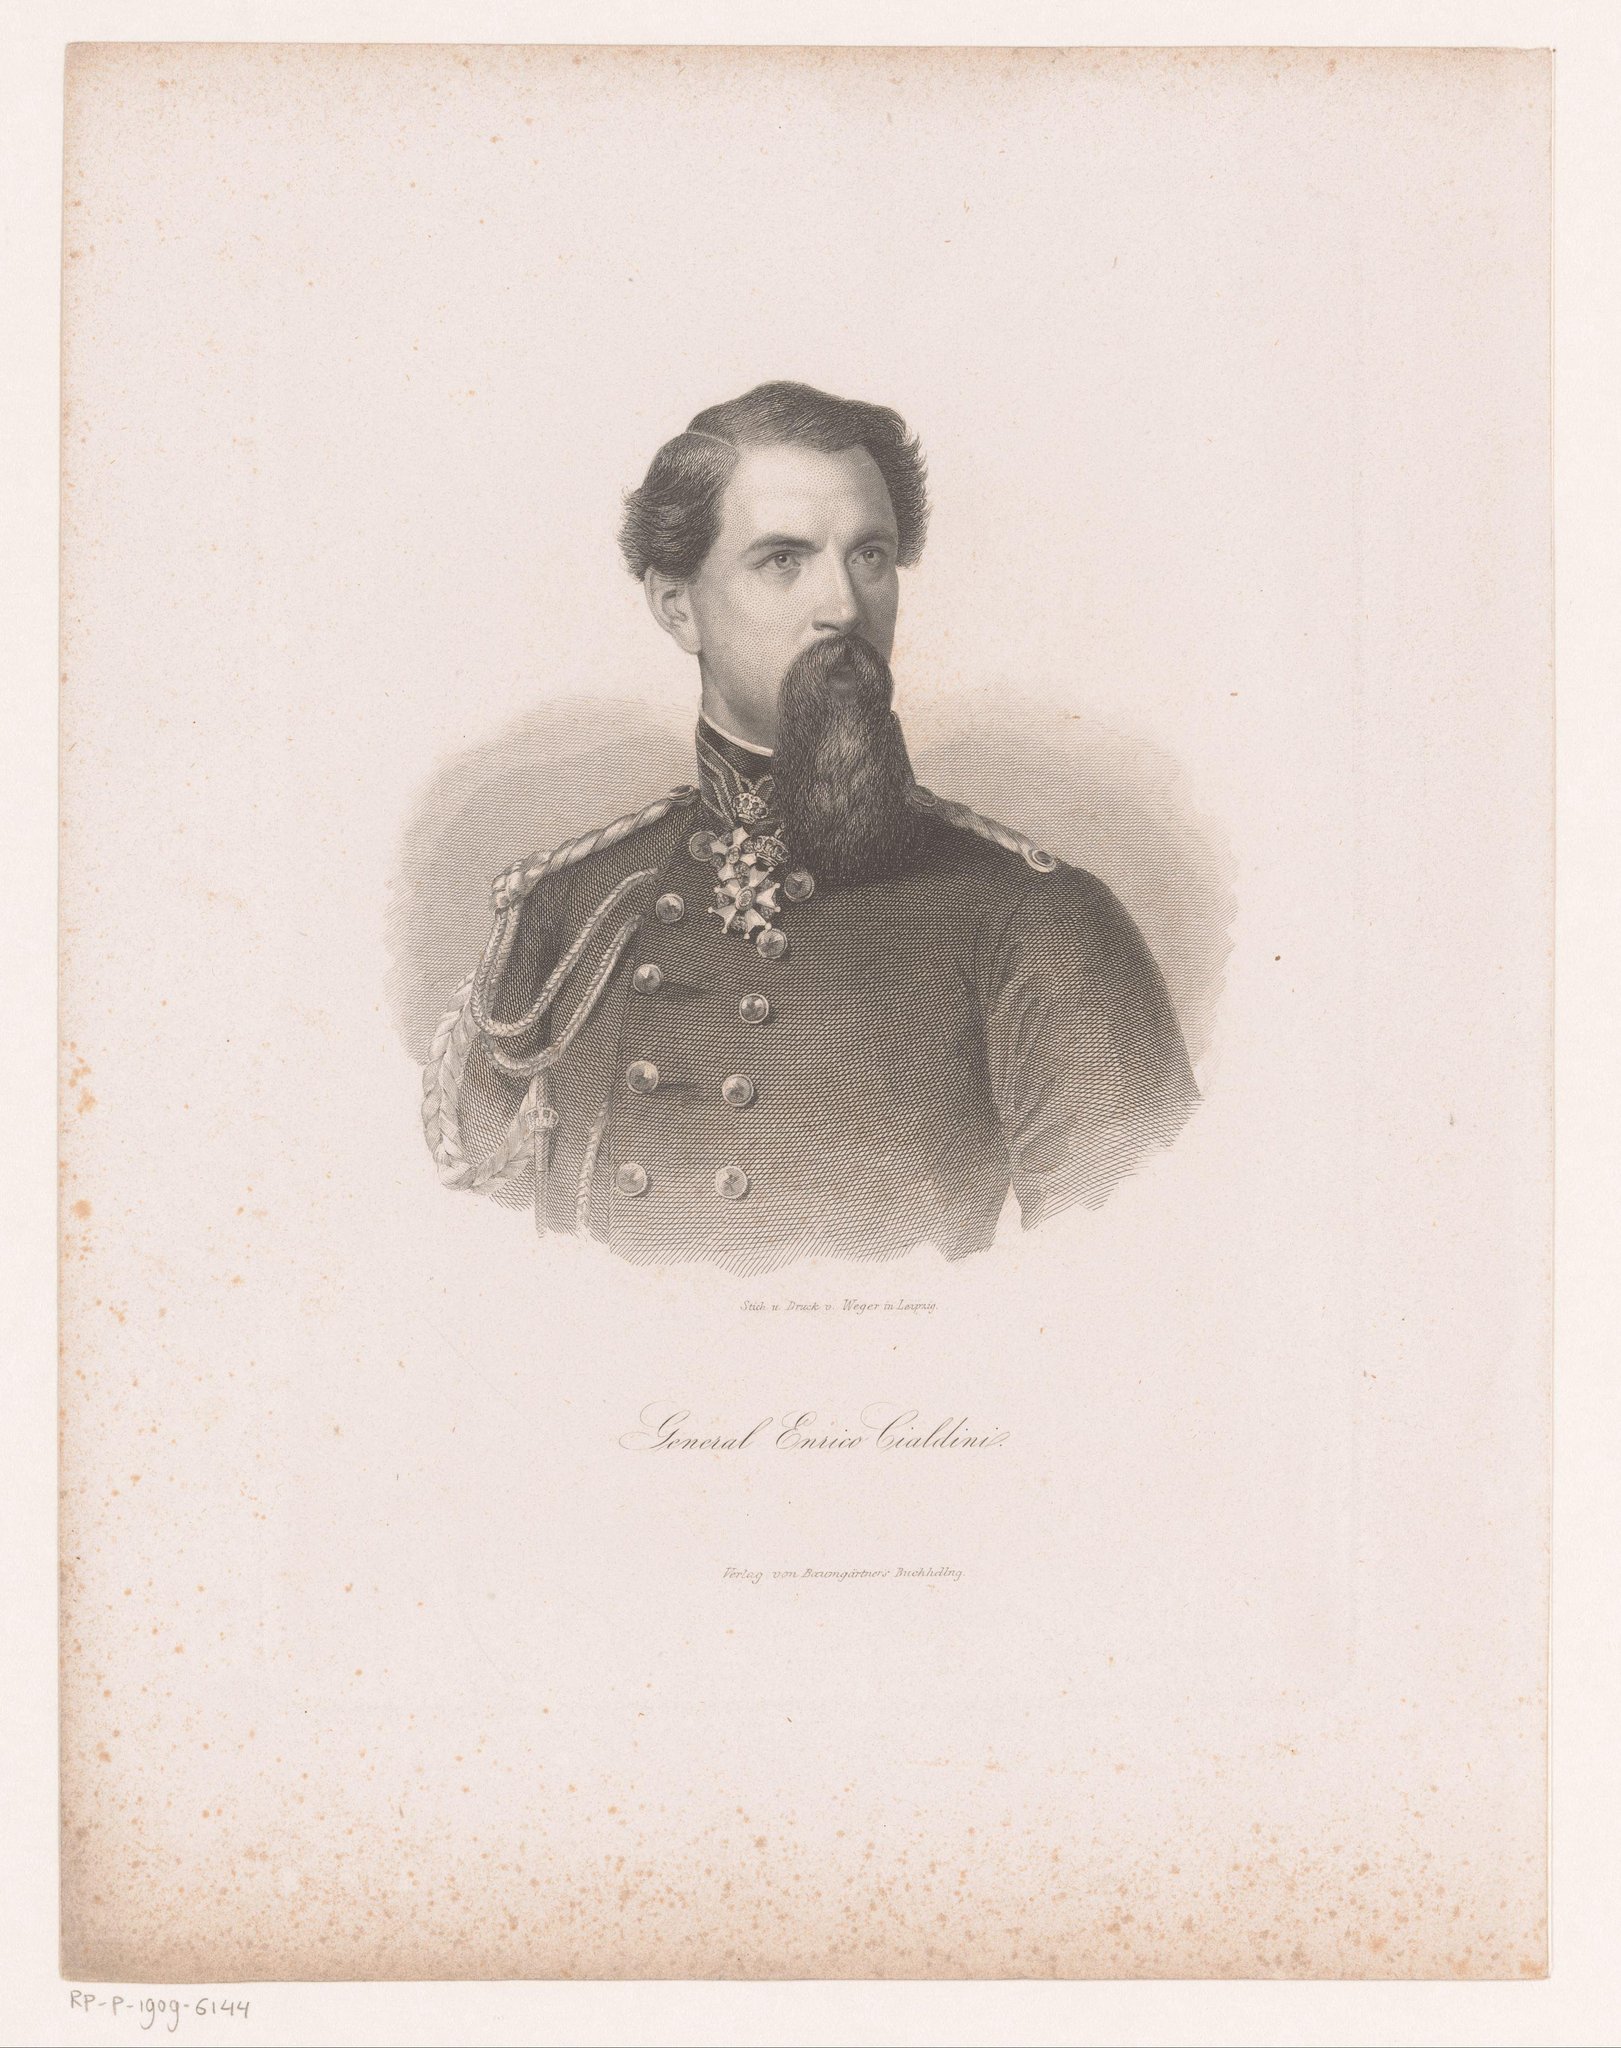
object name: print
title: Portret van Enrico Cialdini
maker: august weger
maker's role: print maker, printer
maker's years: 1823-1892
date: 1849-1892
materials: paper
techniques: engraving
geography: leipzig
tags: historical persons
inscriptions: collector's mark: Lugt 2228